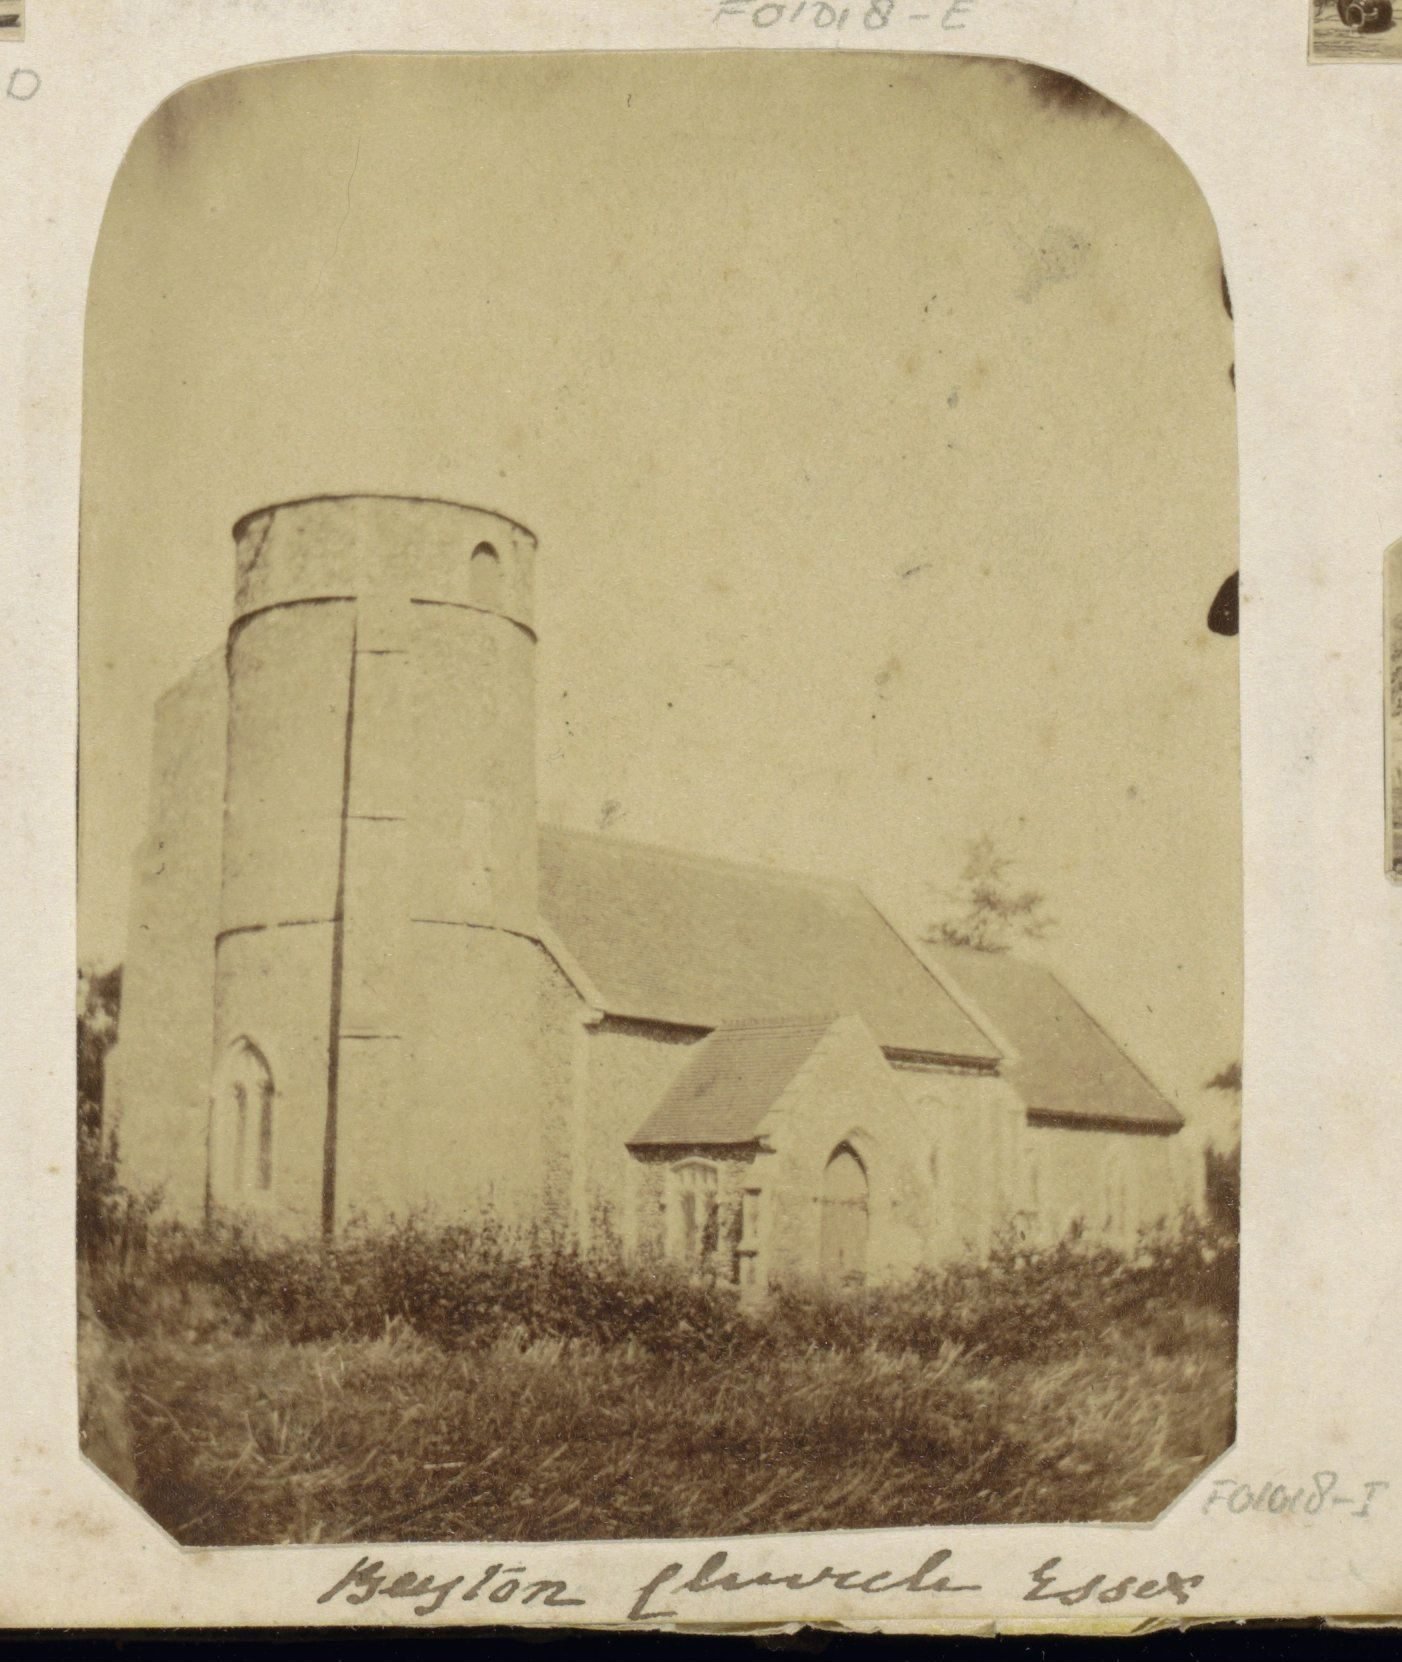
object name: photograph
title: Exterieur van de All Saintskerk in Beyton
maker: Anonymous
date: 1860-1870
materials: paper, photographic support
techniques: albumen print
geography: beyton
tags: church (exterior) - qq - small church, chapel, parts of church exterior and annexes: tower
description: Onderdeel van Engels familiealbum met foto's van personen, reizen, cricket en kunstwerken.